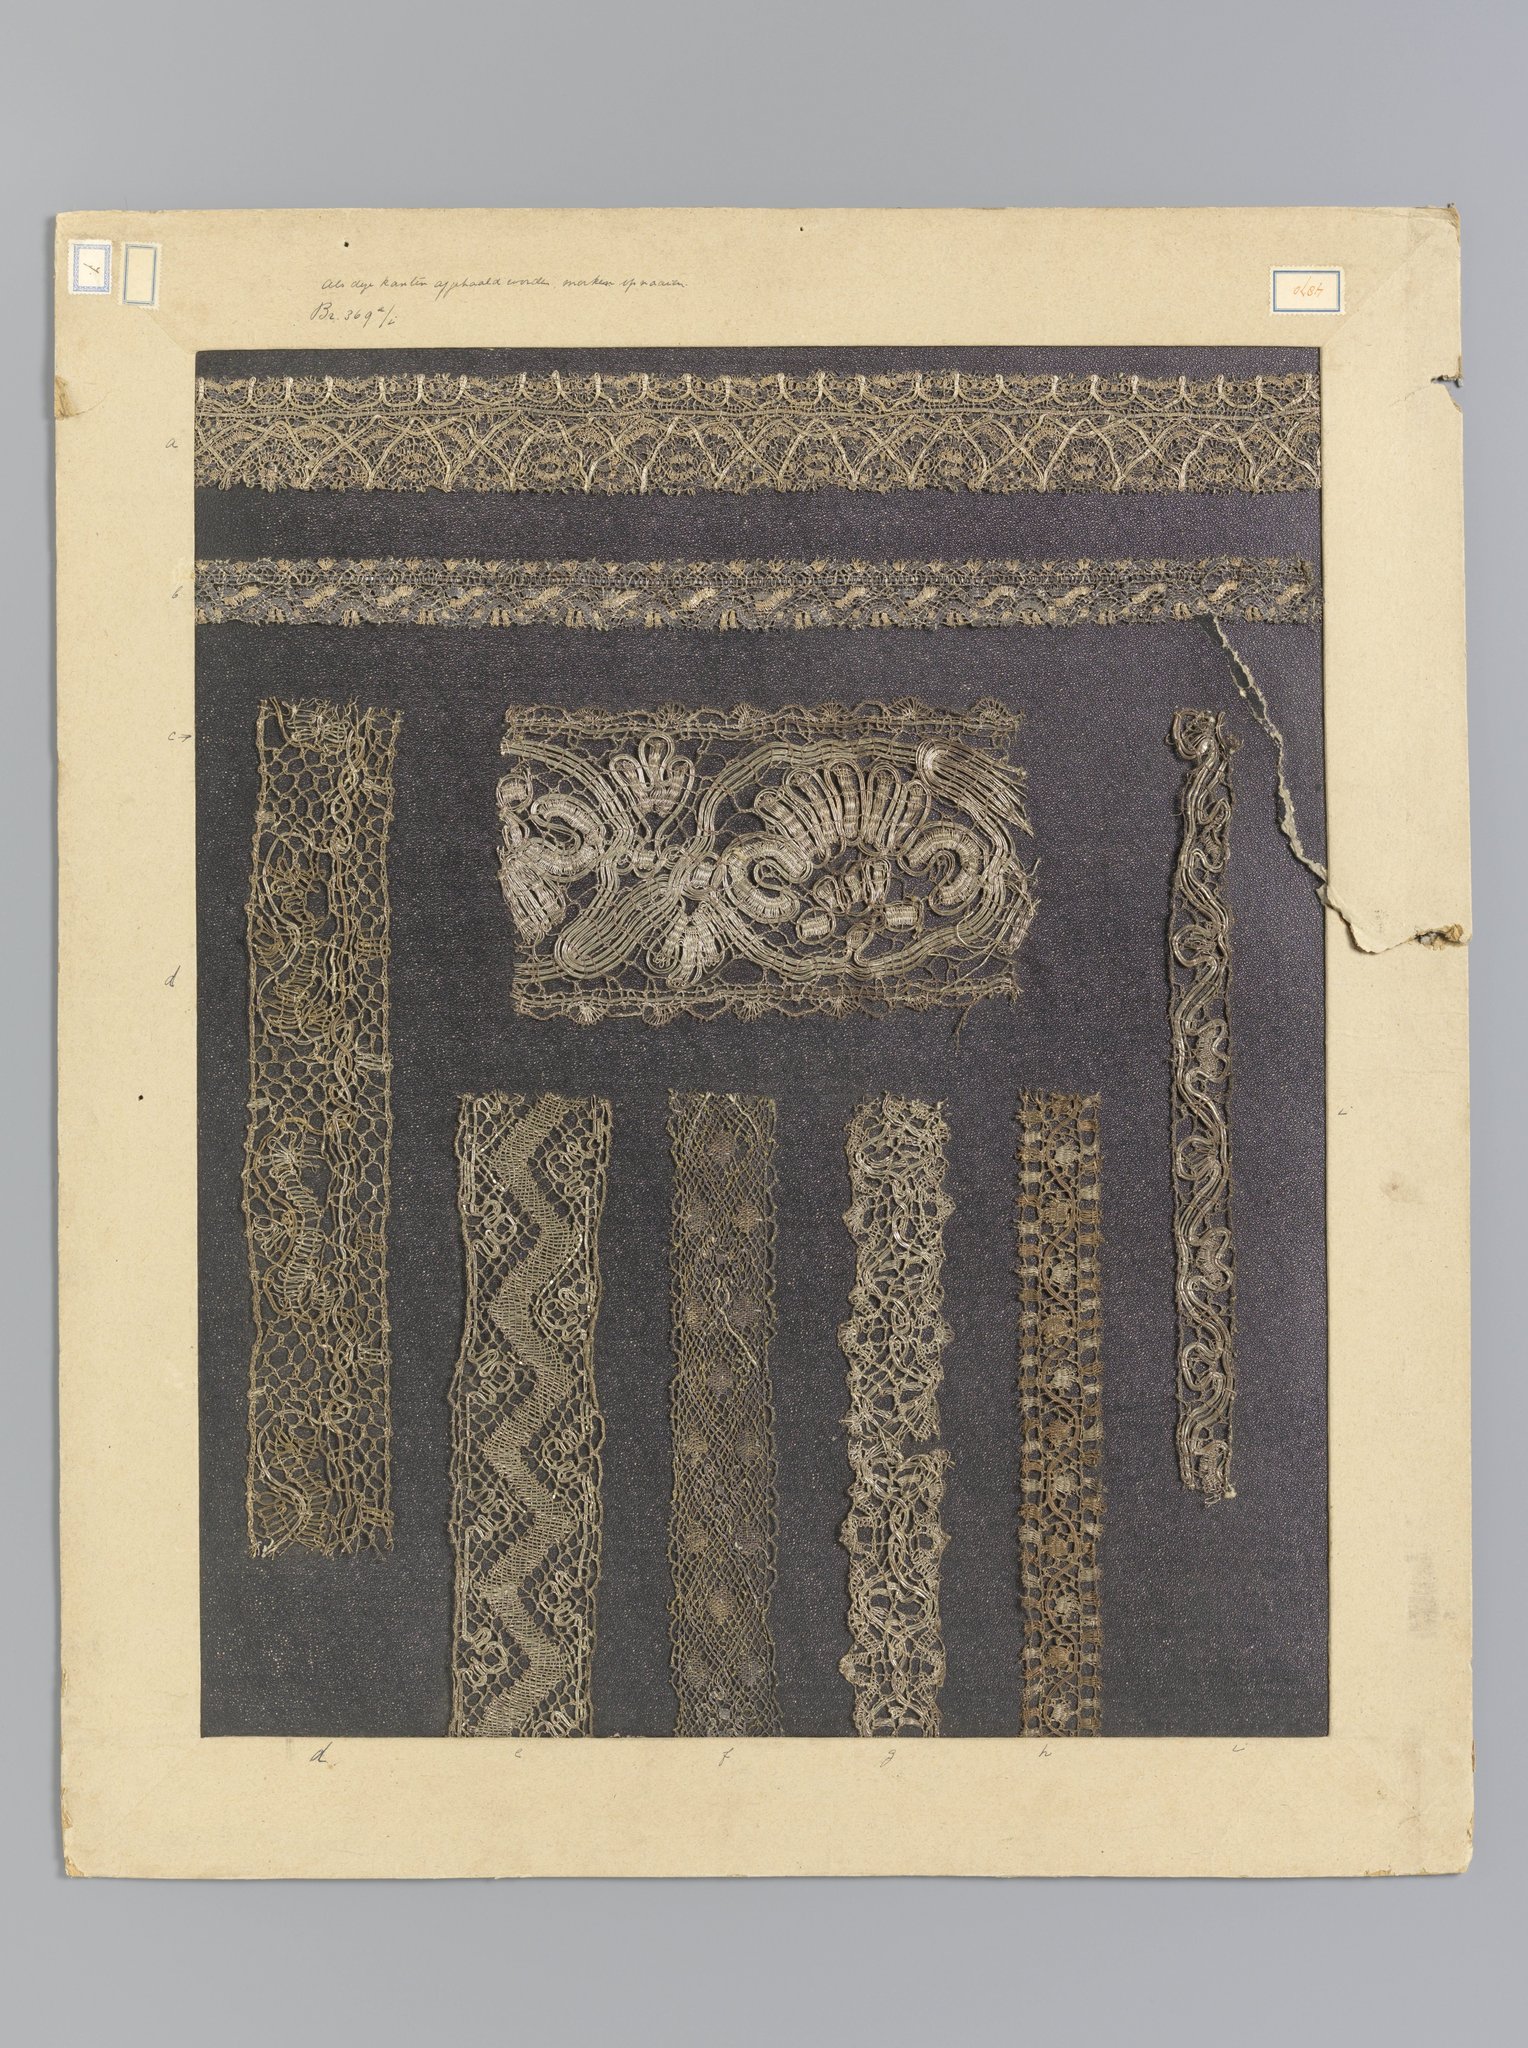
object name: strip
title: Negen stroken zilverkant en goudkant op karton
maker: Anonymous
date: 1600-1899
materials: metal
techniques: lace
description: Karton waarop negen stroken kant zijn vastgezet. Het gaat om zilverkant en goudkant, waarbij de zilver- en goudkleurige draden al dan niet in combinatie zijn gebruikt. Op het karton staan naast de stroken van boven naar beneden (links) de letters a t/m d en van links naar rechts (onder) de letters d t/m i geschreven.